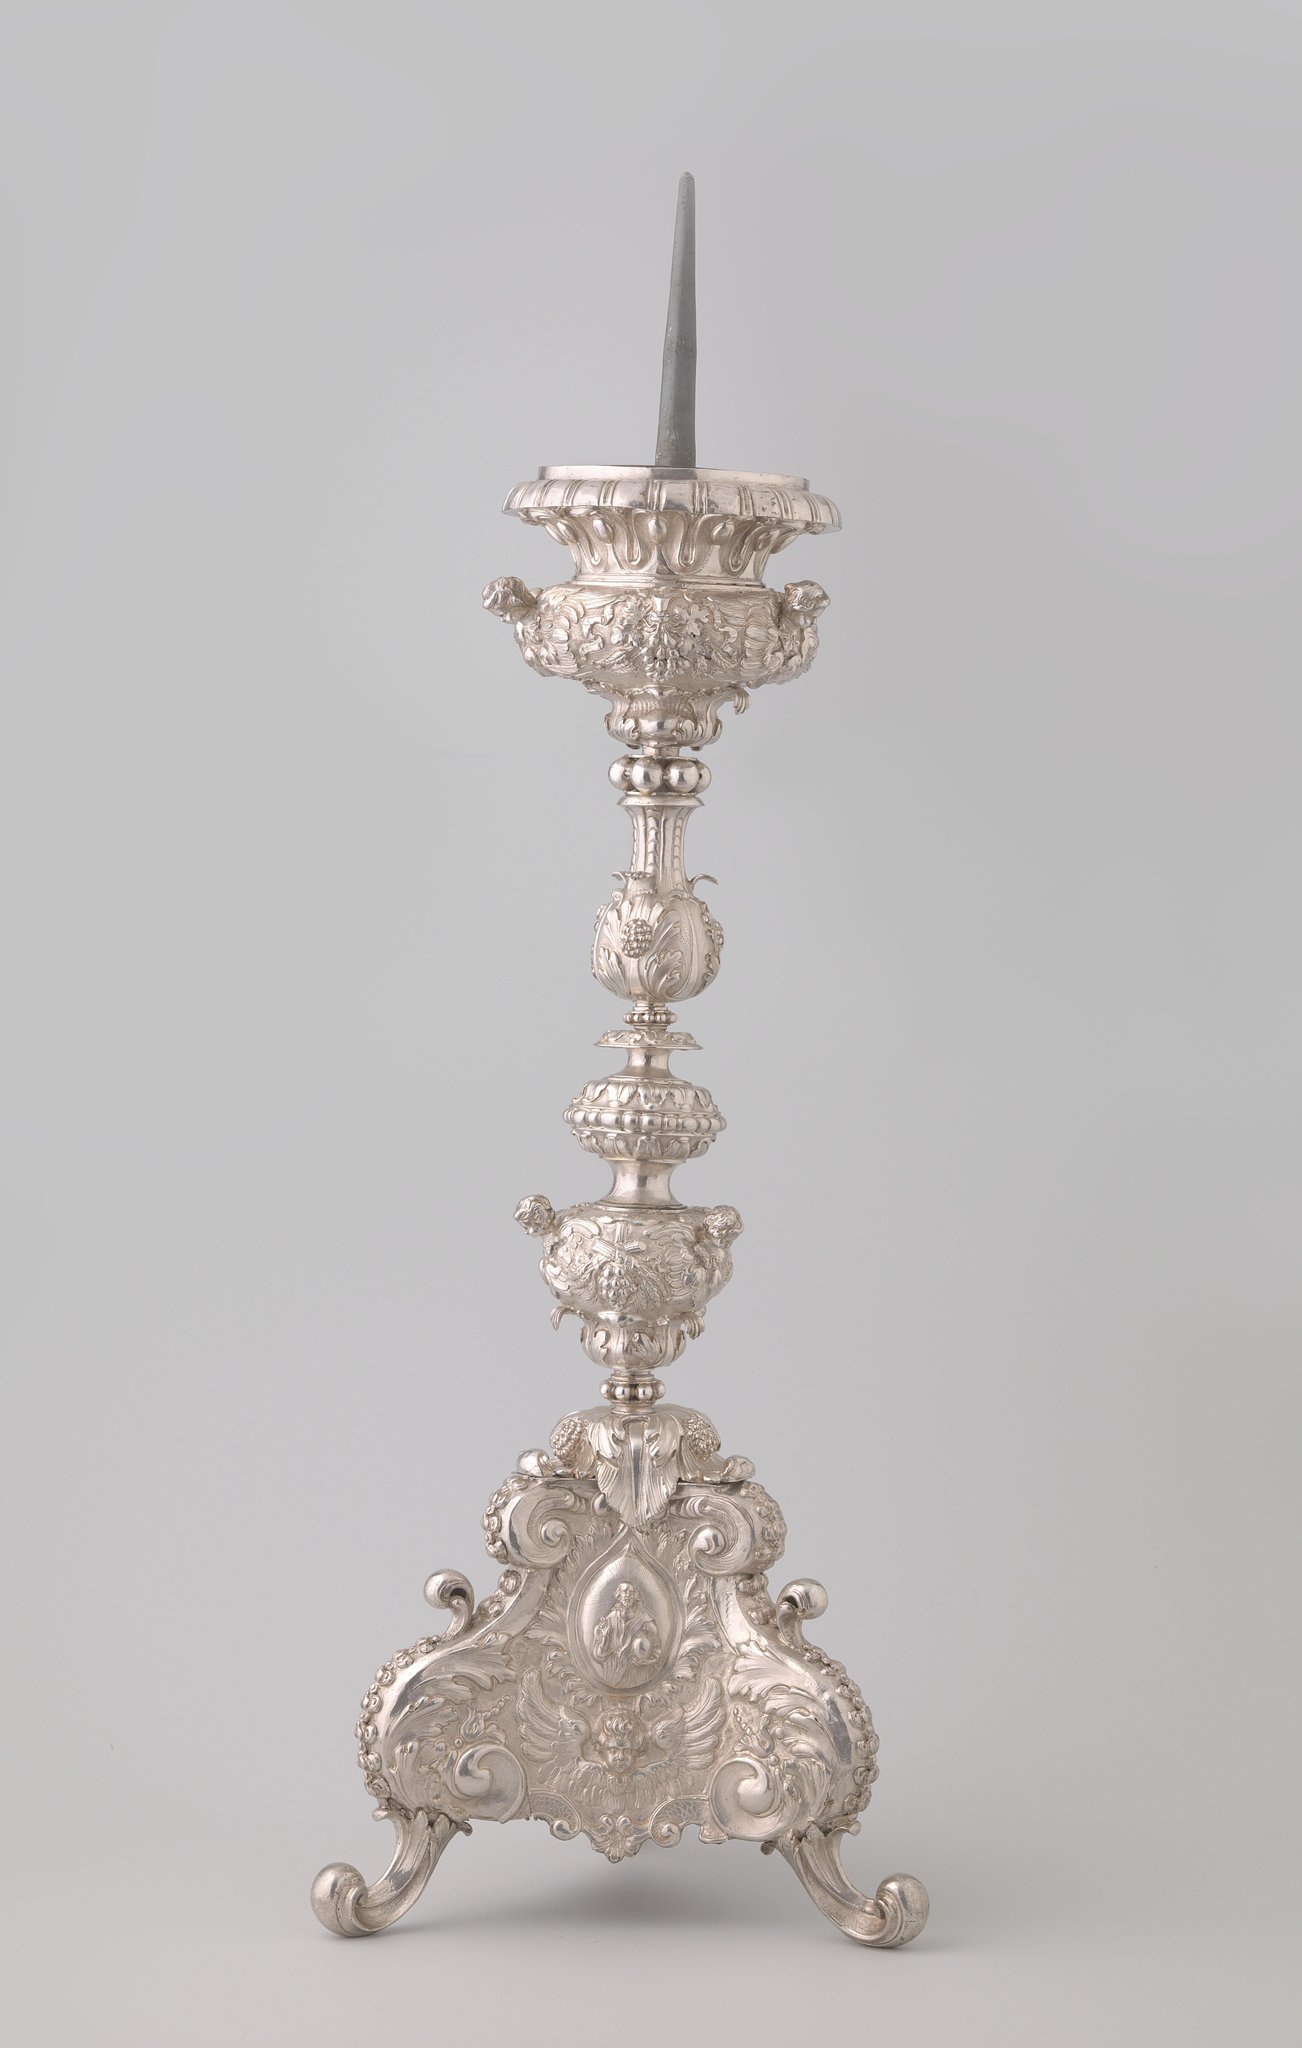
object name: kerkkandelaar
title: Kandelaar van zilver met vijfdelig gelede balusterstam op driehoekige voet met voluutpoten. Versierd met medaillons waarin Christus, Petrus en Ignatius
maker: jos hannekin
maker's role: silversmith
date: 1701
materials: silver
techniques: gilding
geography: antwerp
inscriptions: mark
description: Six altar candlesticks. Silver. Antwerp, 1701, by Jos Hannekin.